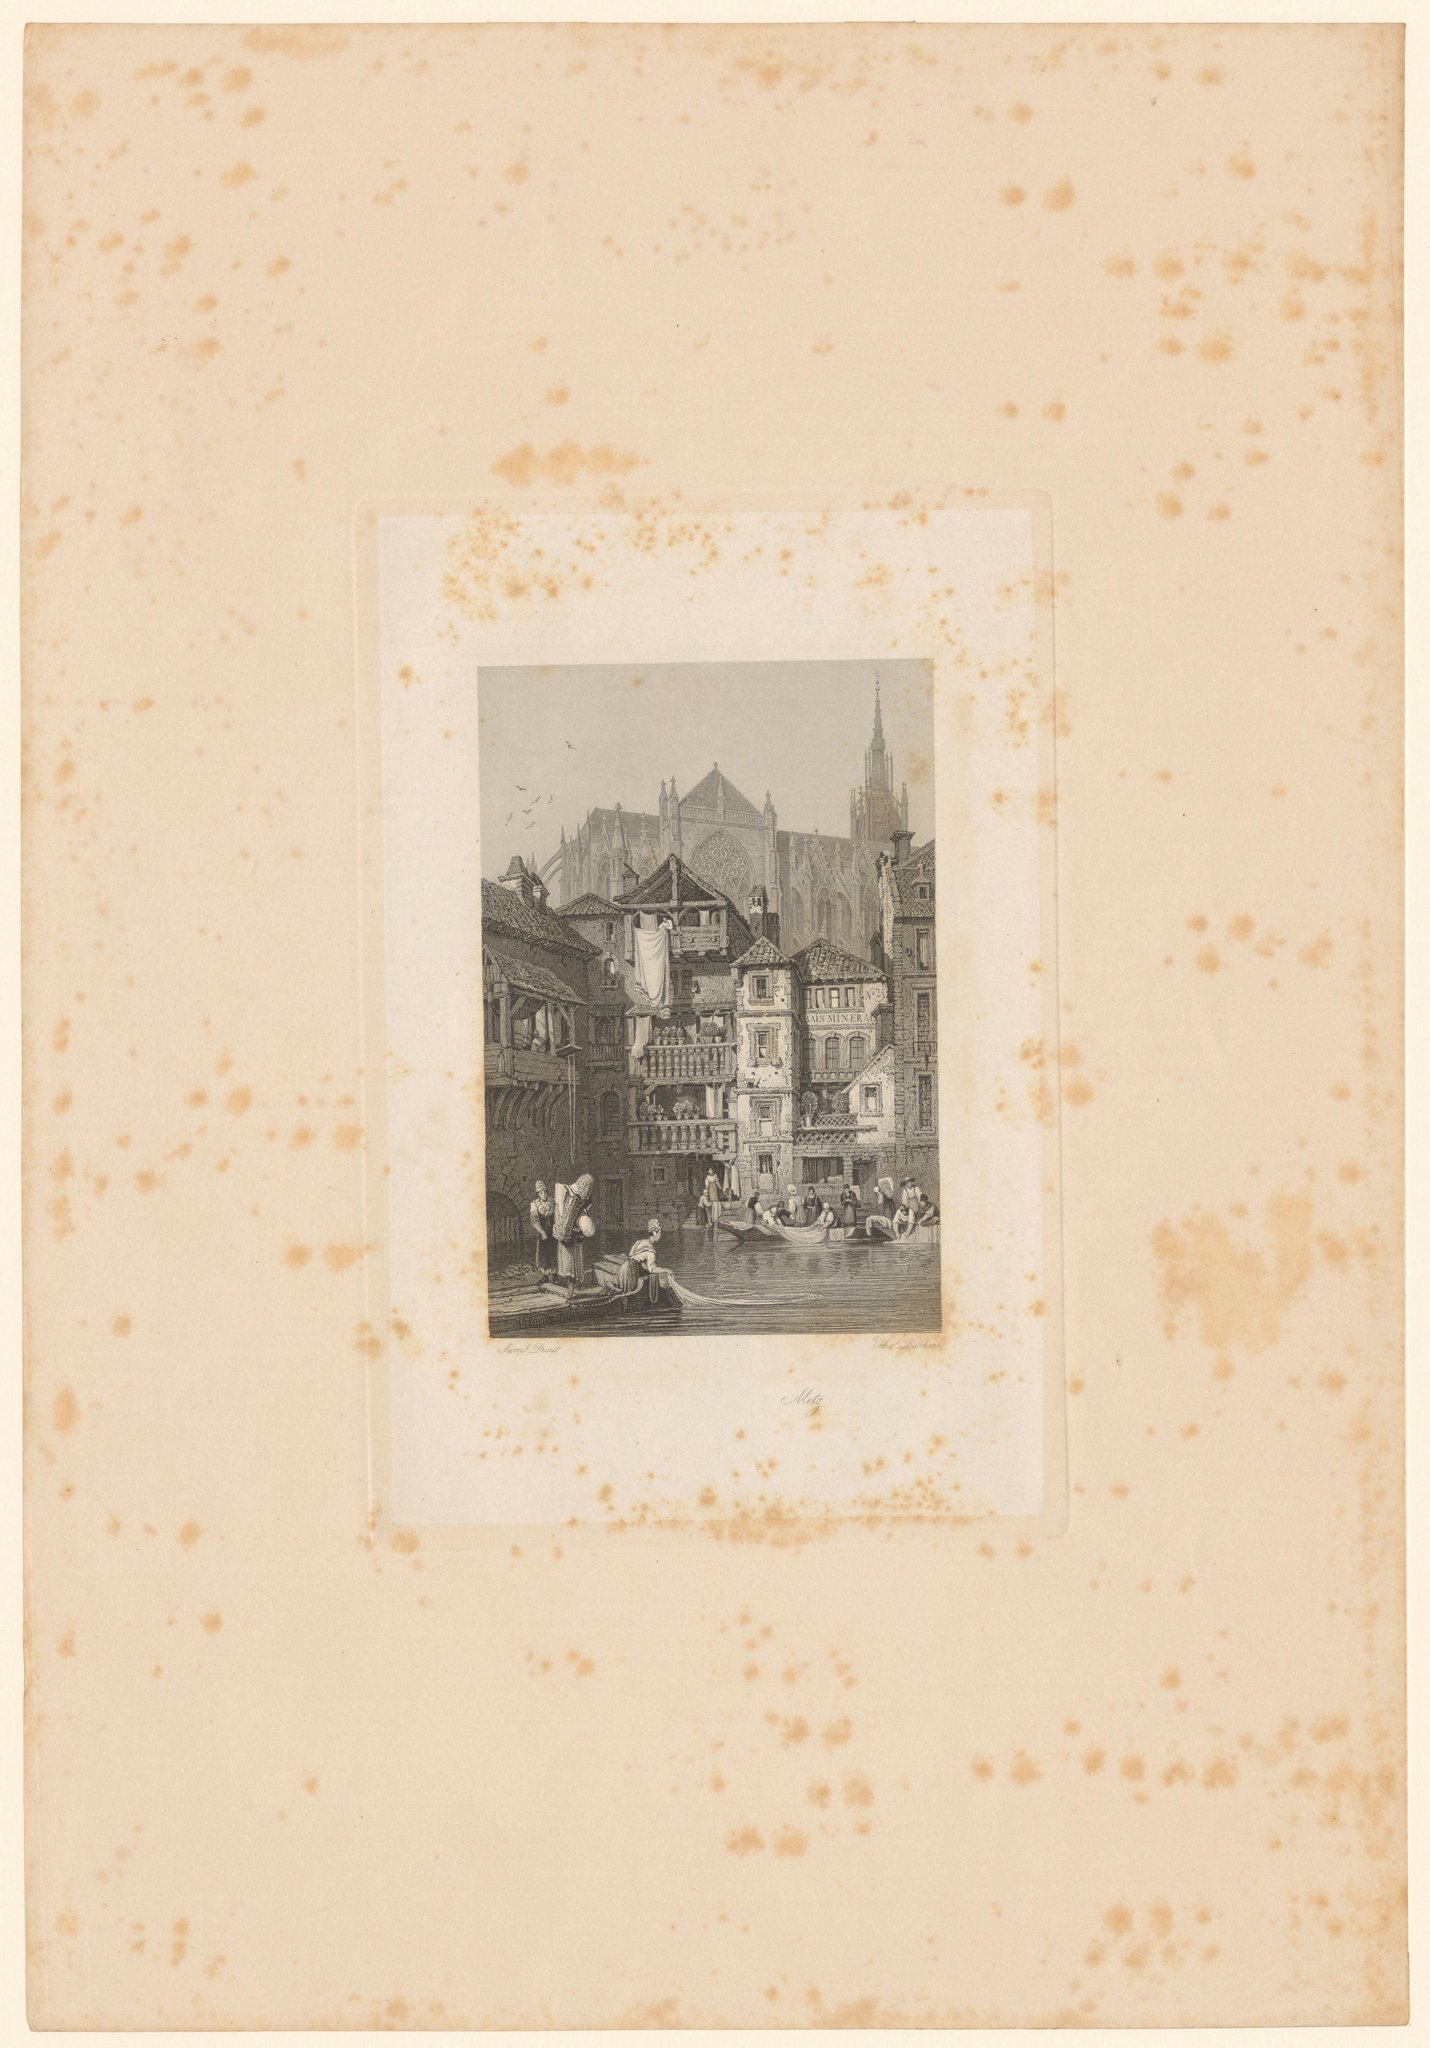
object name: print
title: Metz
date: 1831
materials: paper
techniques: engraving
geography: england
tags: church (exterior), canals, waters (in city) (+ city(-scape) with figures, staffage)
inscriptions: collector's mark: Lugt 2228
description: Prent in tweede staat gebruikt in: The Continental annual and romantic cabinet for 1832 with illustrations by Samuel Prout. Londen: Smith, Elder & Co., [1831], tussen p. 62 en 63.